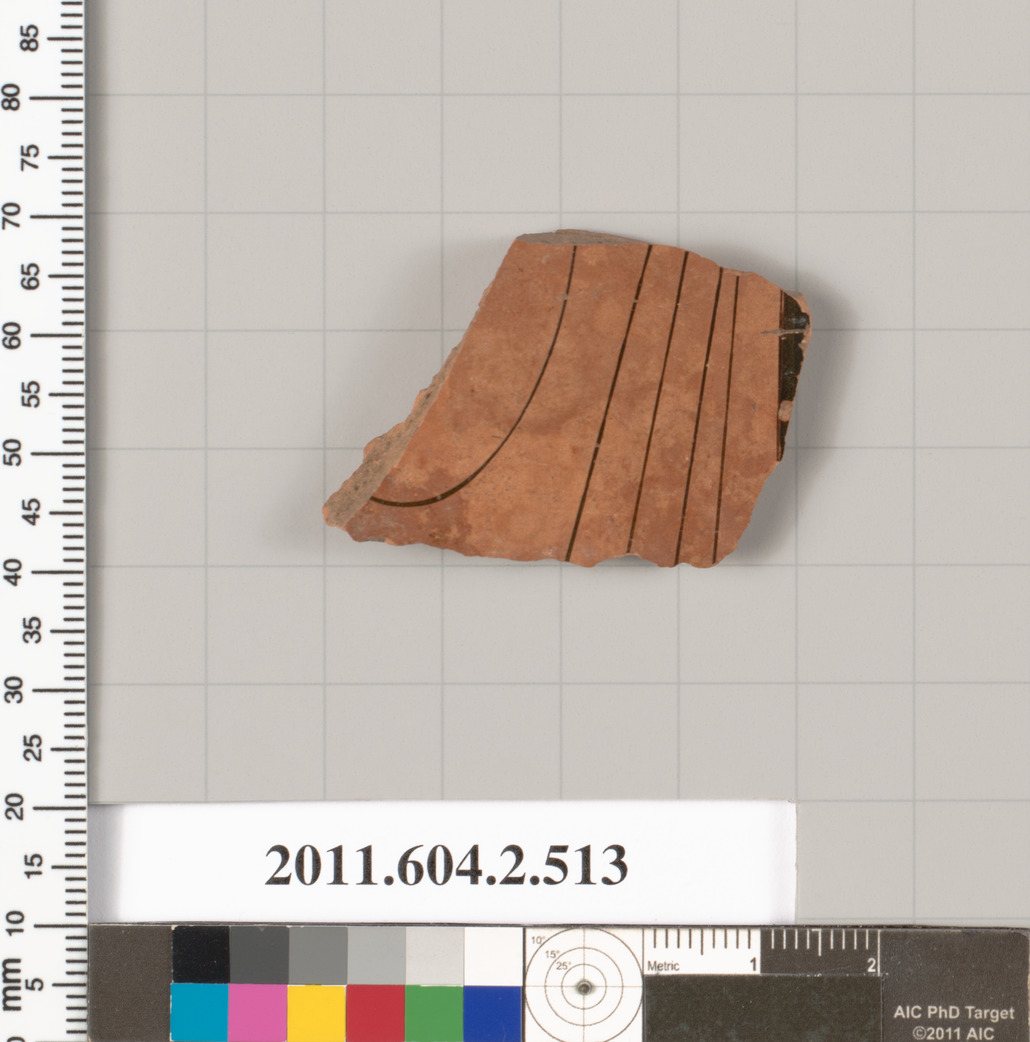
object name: column krater fragment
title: Terracotta fragment of a column-krater (bowl for mixing wine and water)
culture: greek, attic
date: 460-440 BCE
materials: terracotta